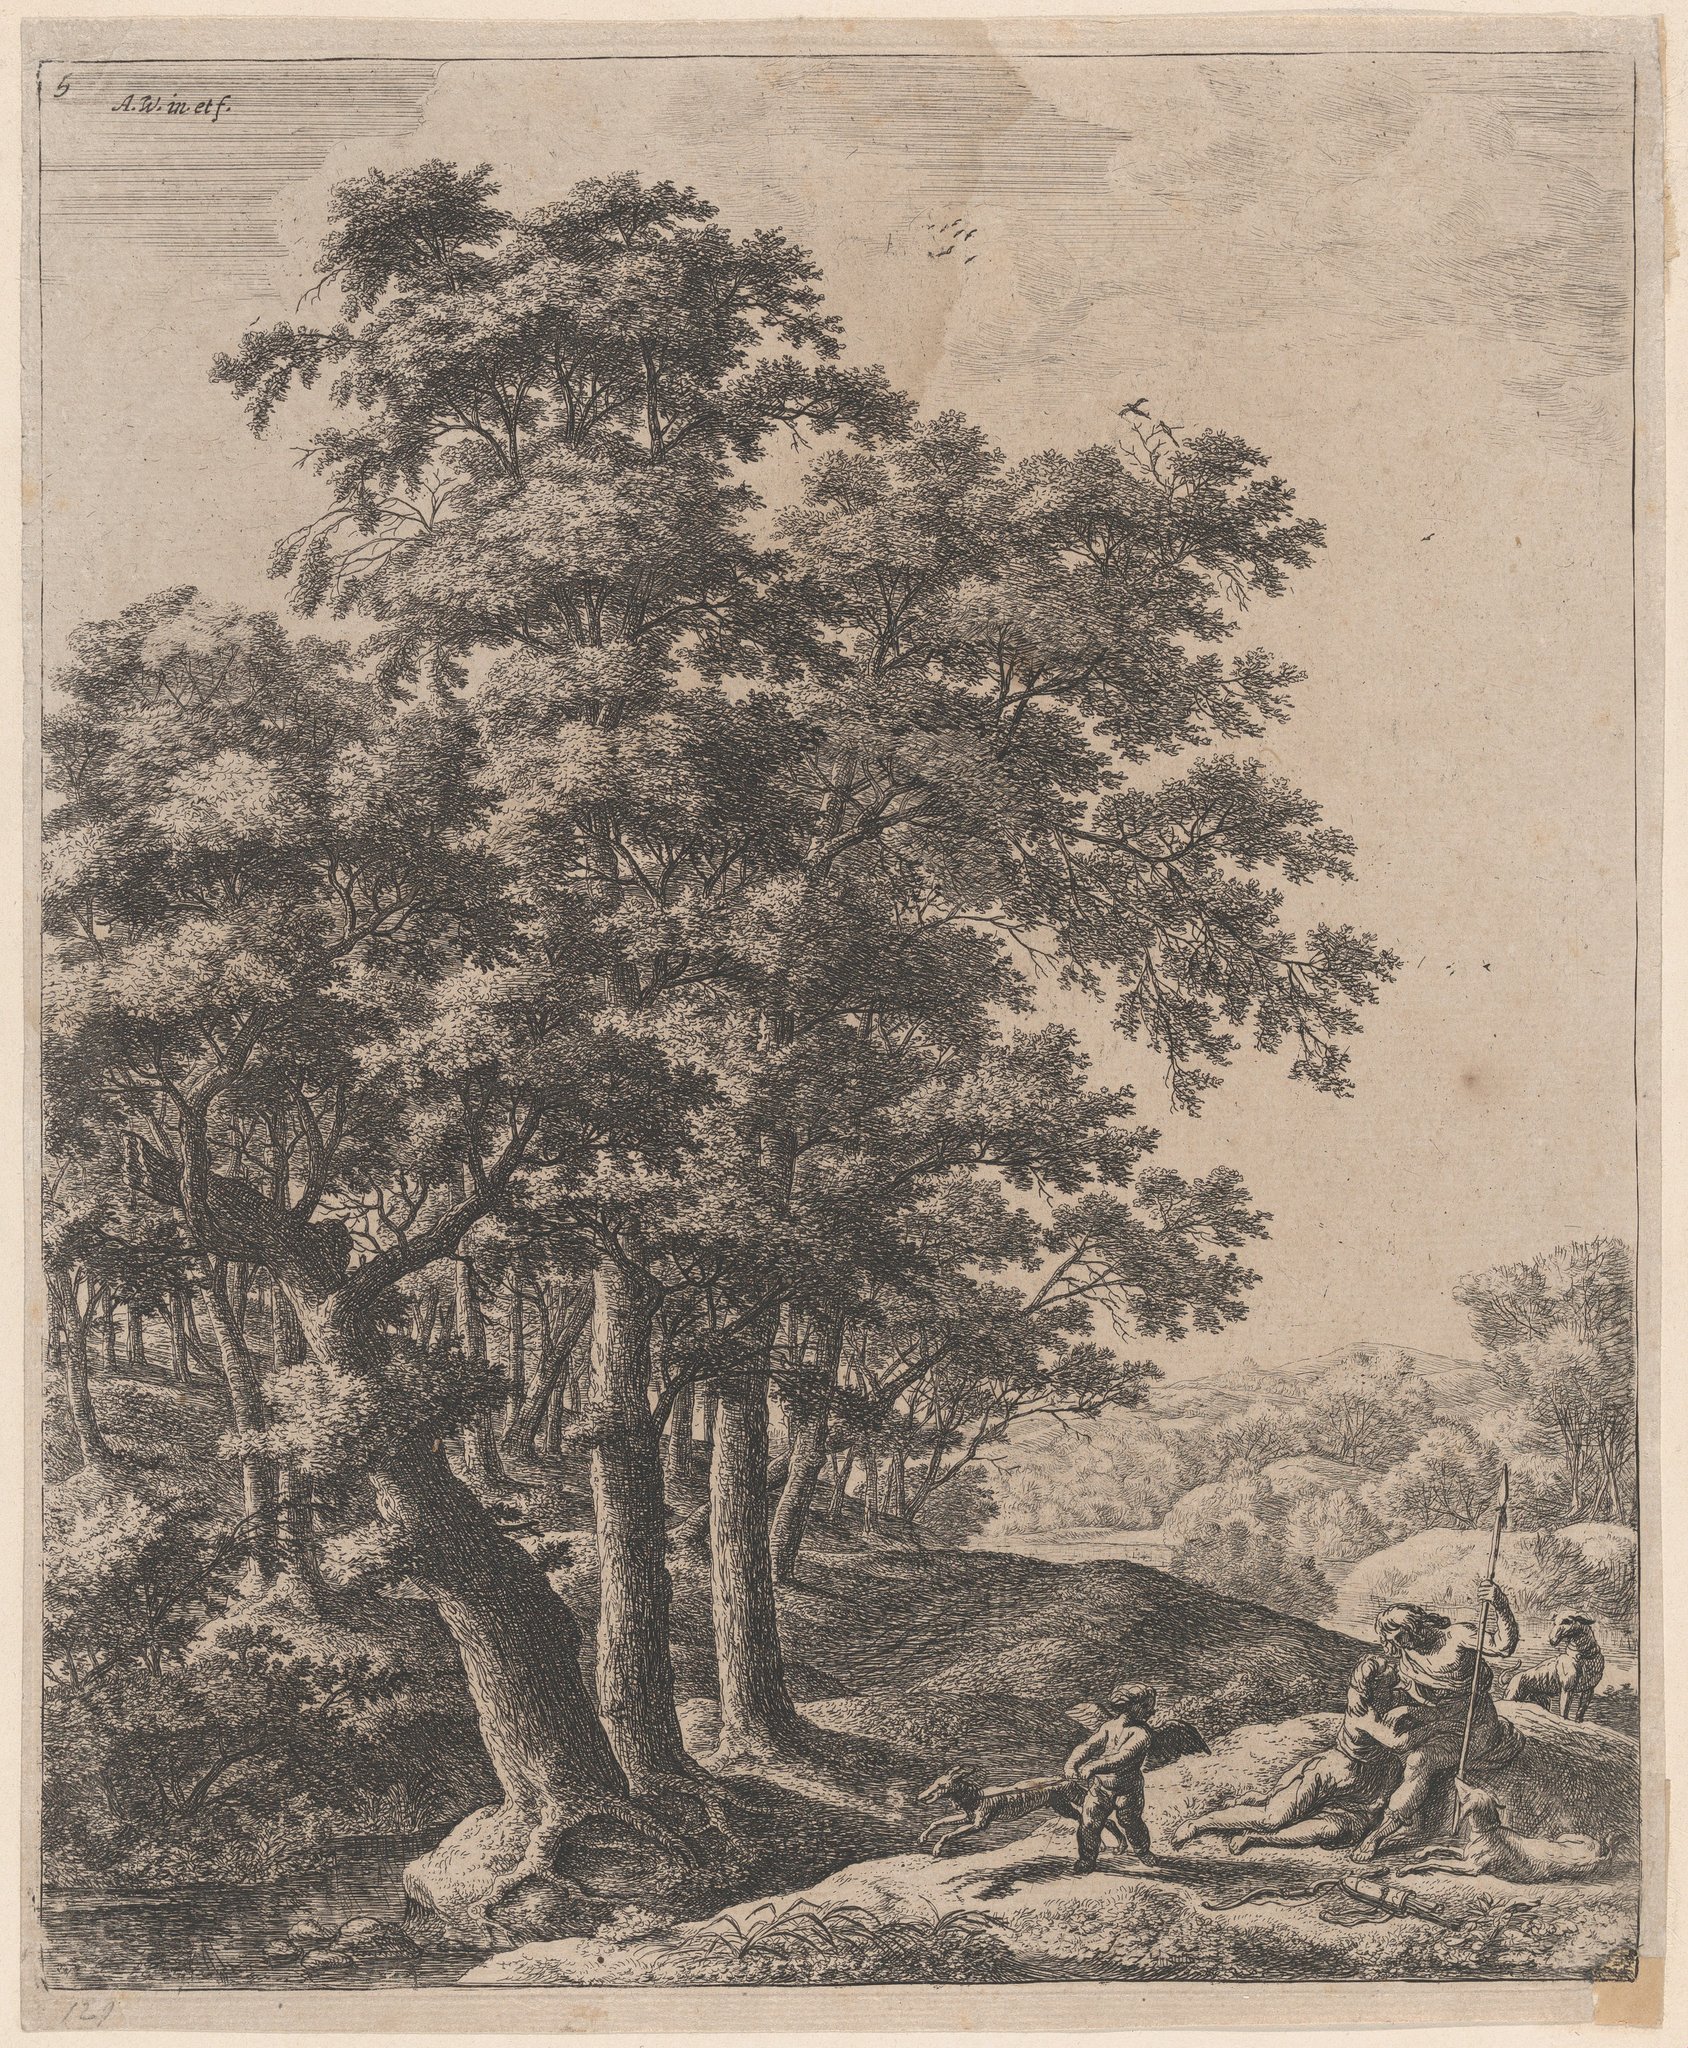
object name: print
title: Venus and Adonis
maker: anthonie waterloo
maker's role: artist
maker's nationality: dutch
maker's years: 1609-1690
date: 1601-1700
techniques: etching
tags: adonis,venus,dogs,trees